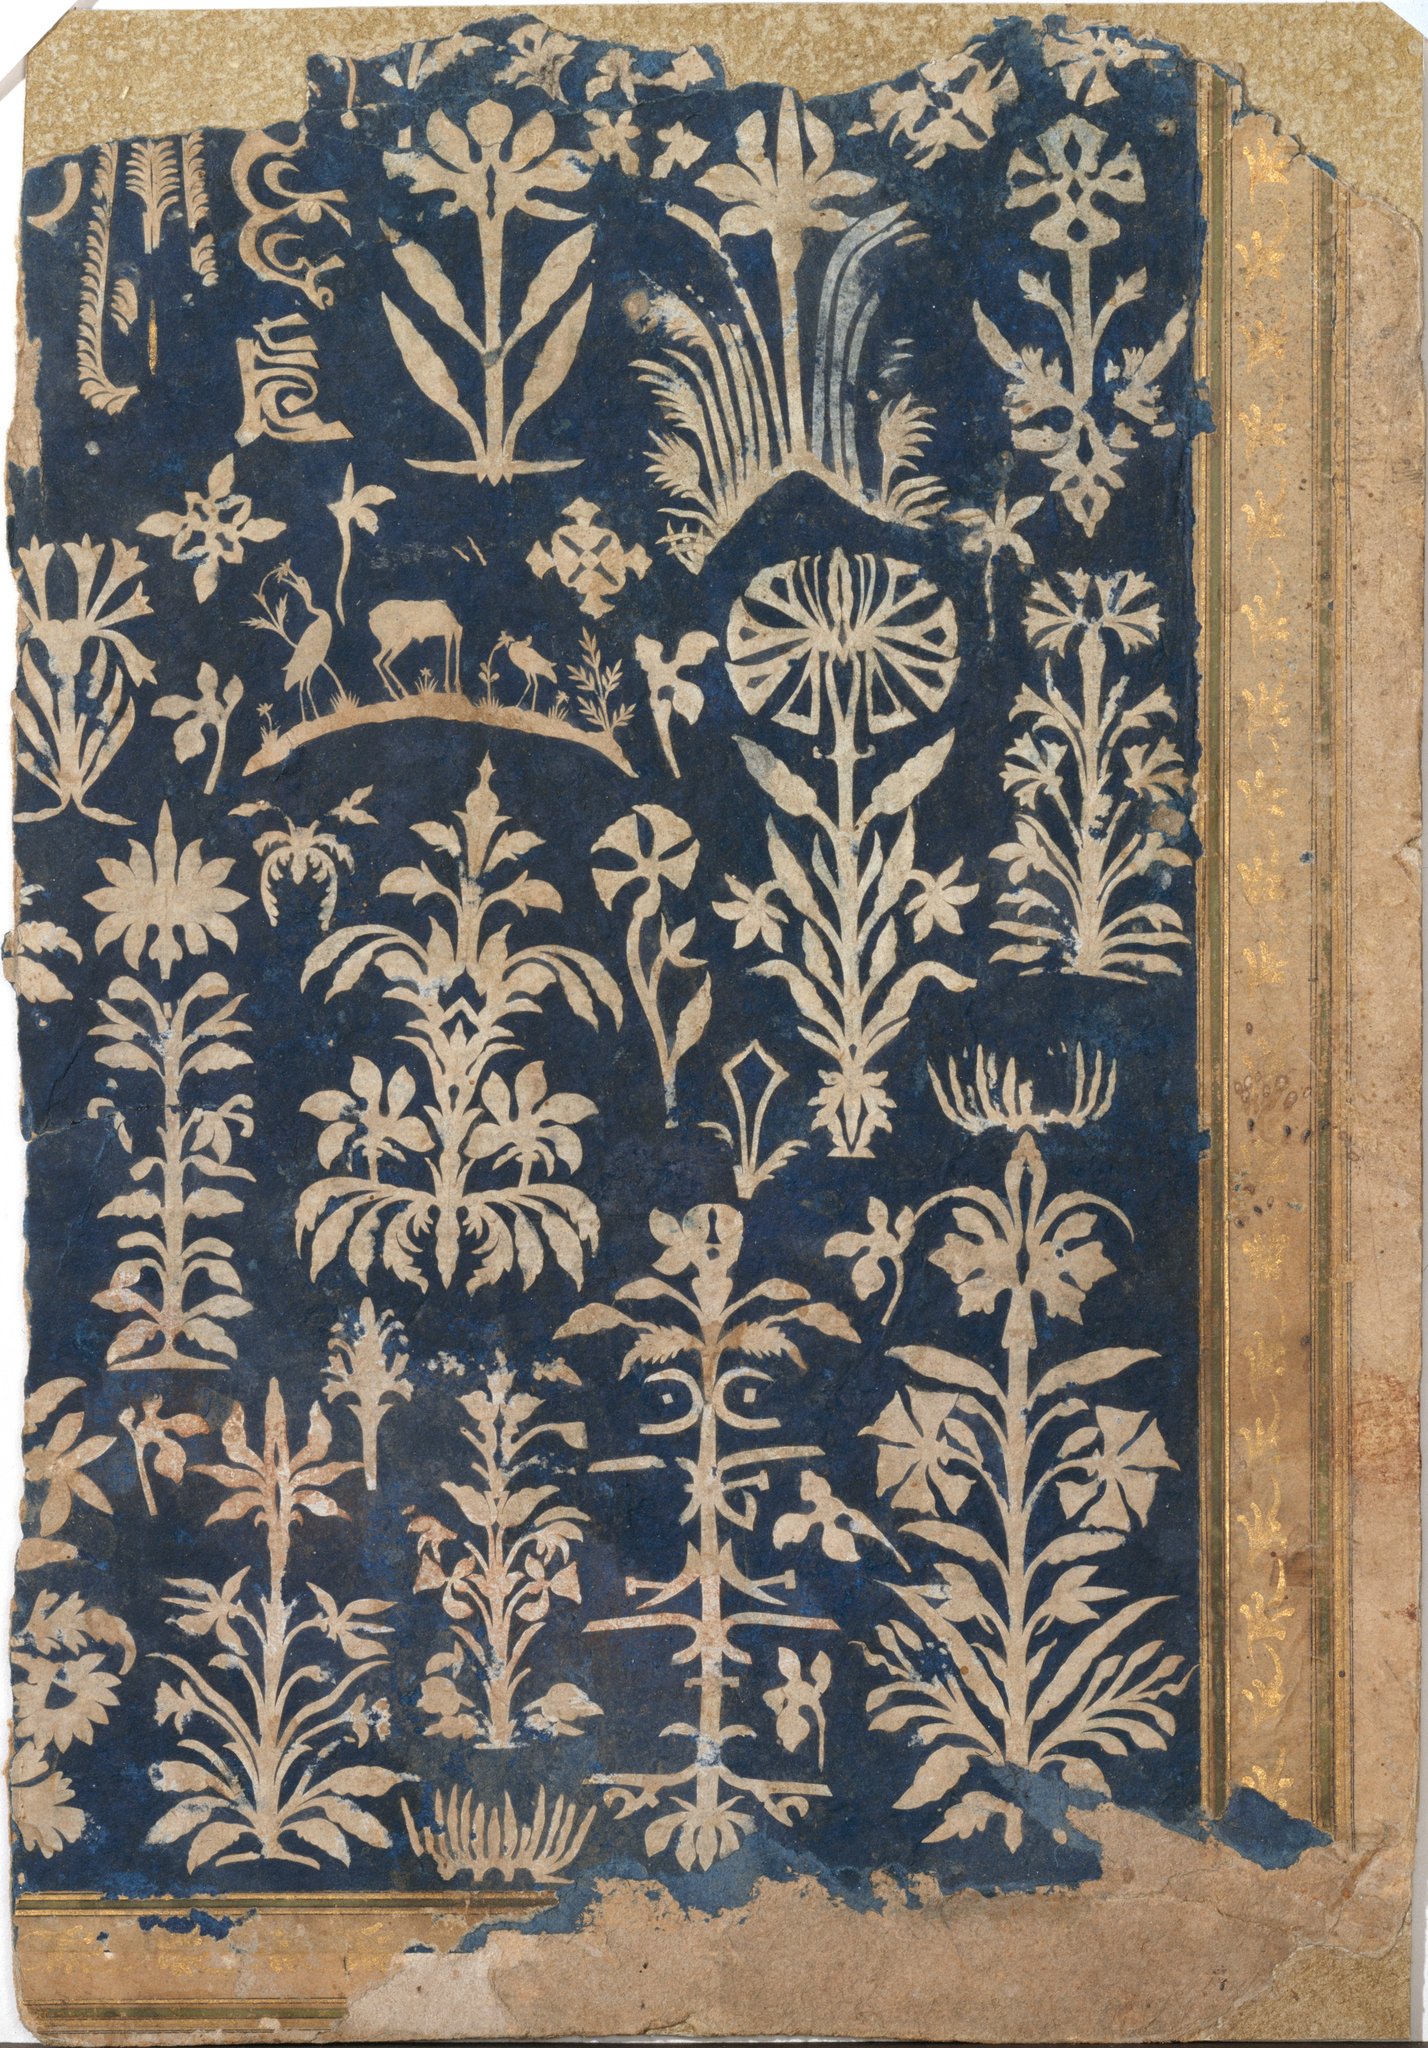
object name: illustrated album leaf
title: Album Page with Cut-Paper Decoration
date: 1625-1650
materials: gold, paper, watercolor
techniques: cutting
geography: india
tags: birds,deer,plants